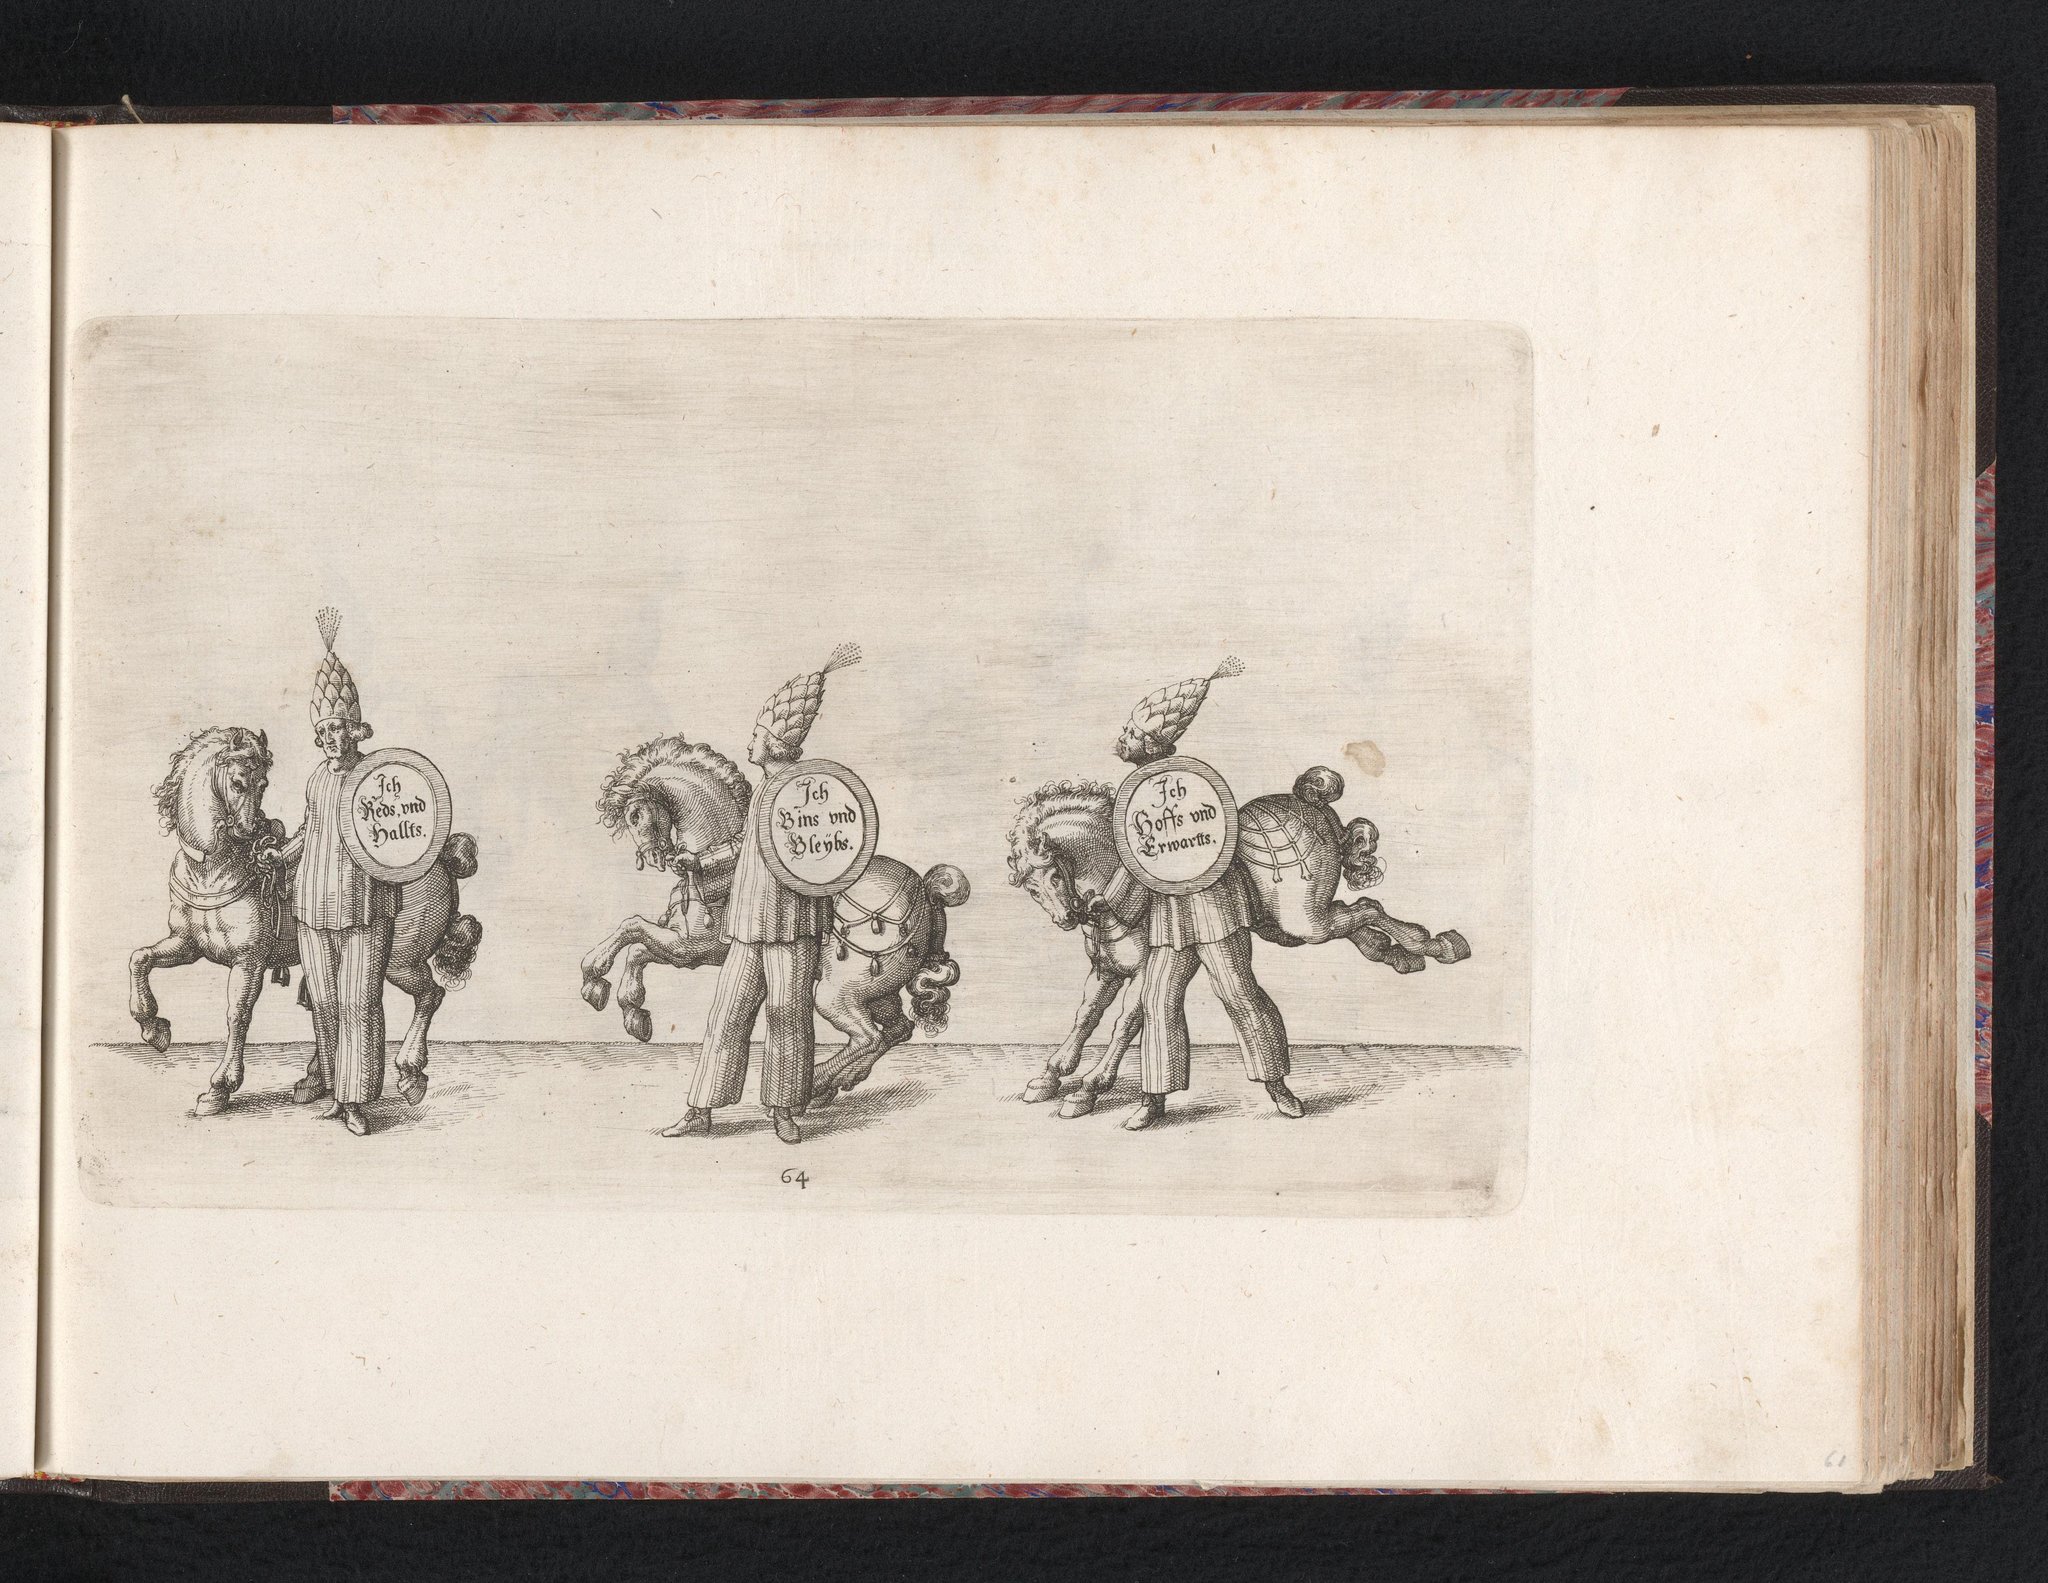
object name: print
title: Geschubde man neemt twee ruiters aan de teugels mee en drie gevleugelde vrouwen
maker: friedrich brentel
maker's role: painter, print maker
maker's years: 1580-1651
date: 1618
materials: paper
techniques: etching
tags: private soldier (+ cavalry, horsemen), good and bad behaviour, moral qualities (opposing concepts), monsters of mixed human and animal shape; 'mostri' (ripa), performance in the open air (pleasure fair), caduceus (staff with two snakes, attribute of mercury)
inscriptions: annotation: ‘63’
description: Tekst in het Duits op de rug en de schilden. Deze prent maakt deel uit van een album.